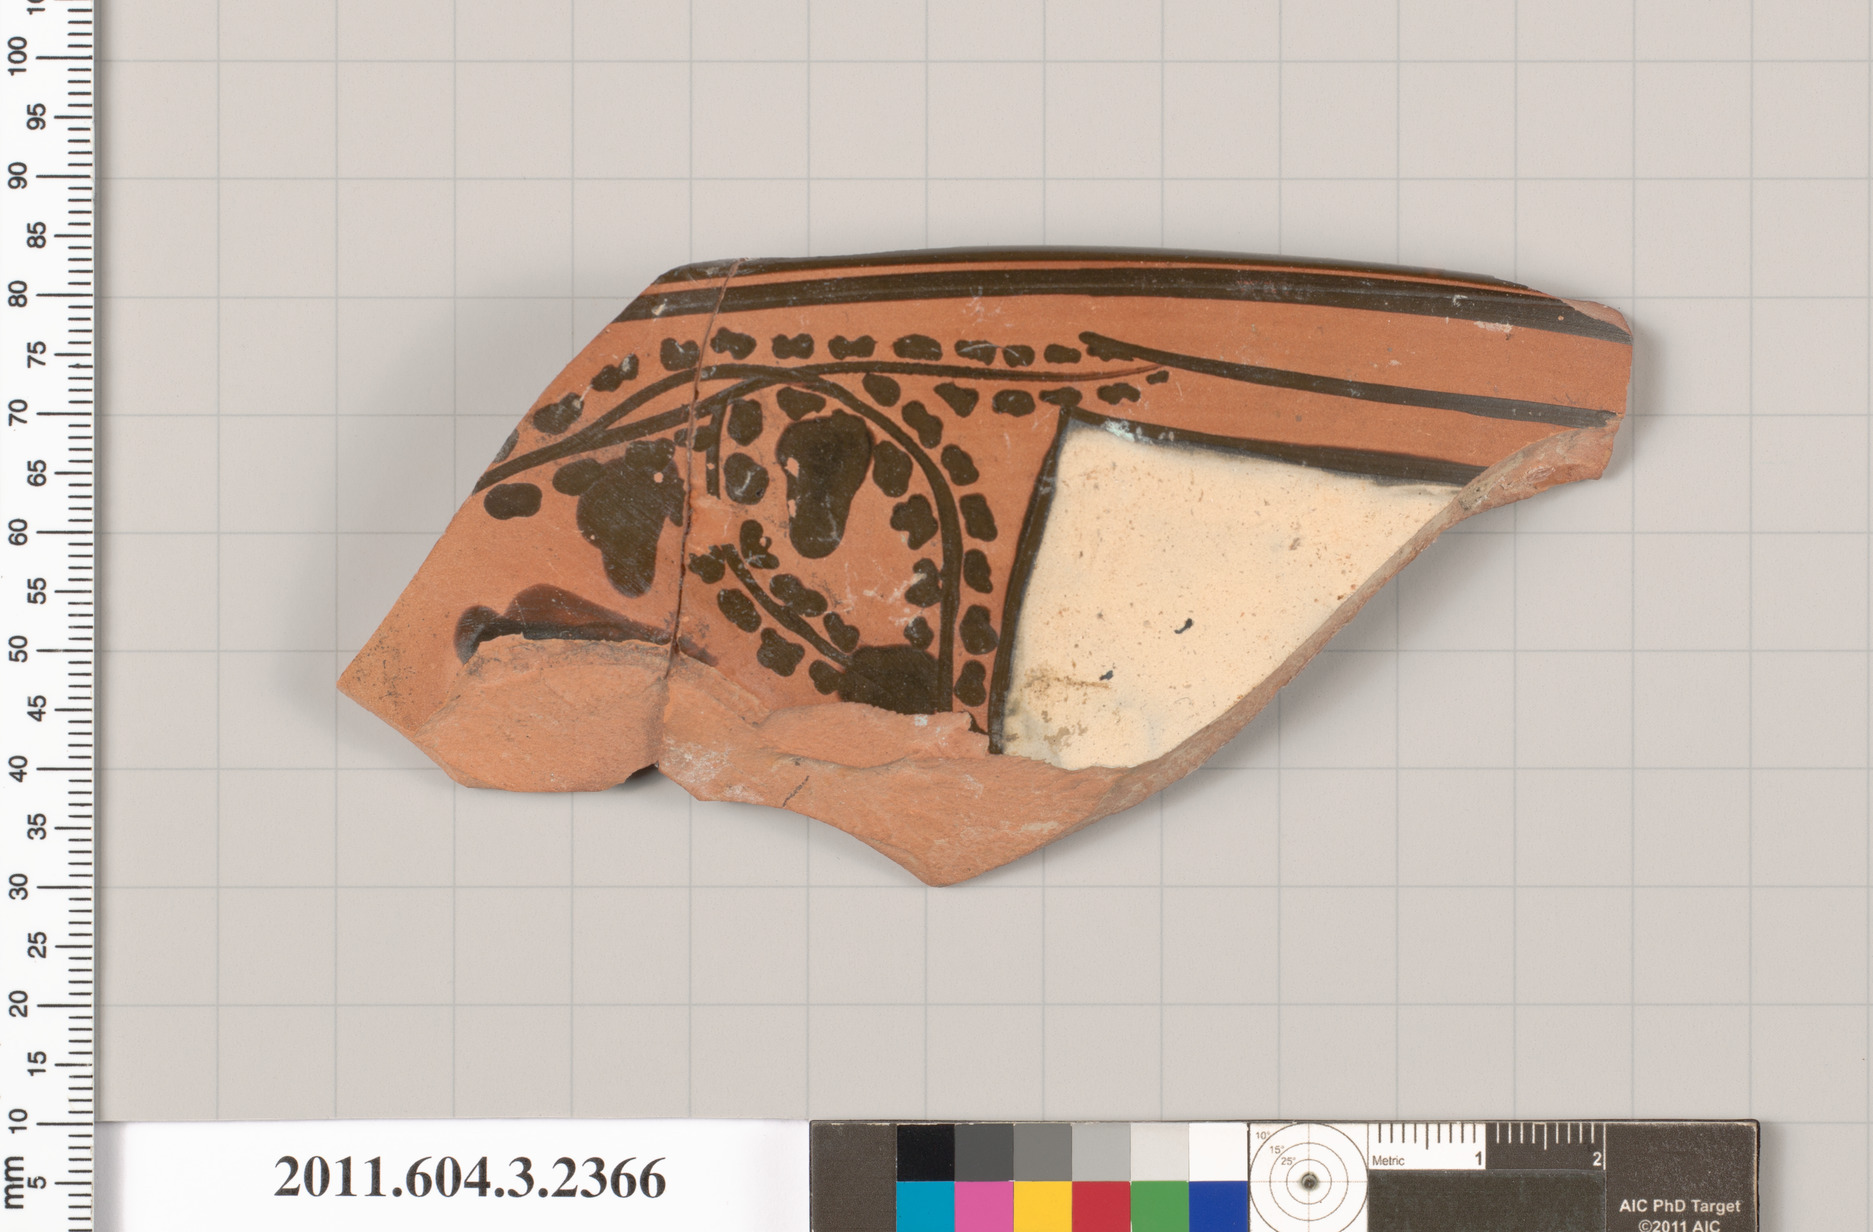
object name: kylix fragment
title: Terracotta rim fragment of a kylix: eye-cup (drinking cup)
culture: greek, attic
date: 540-520 BCE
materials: terracotta